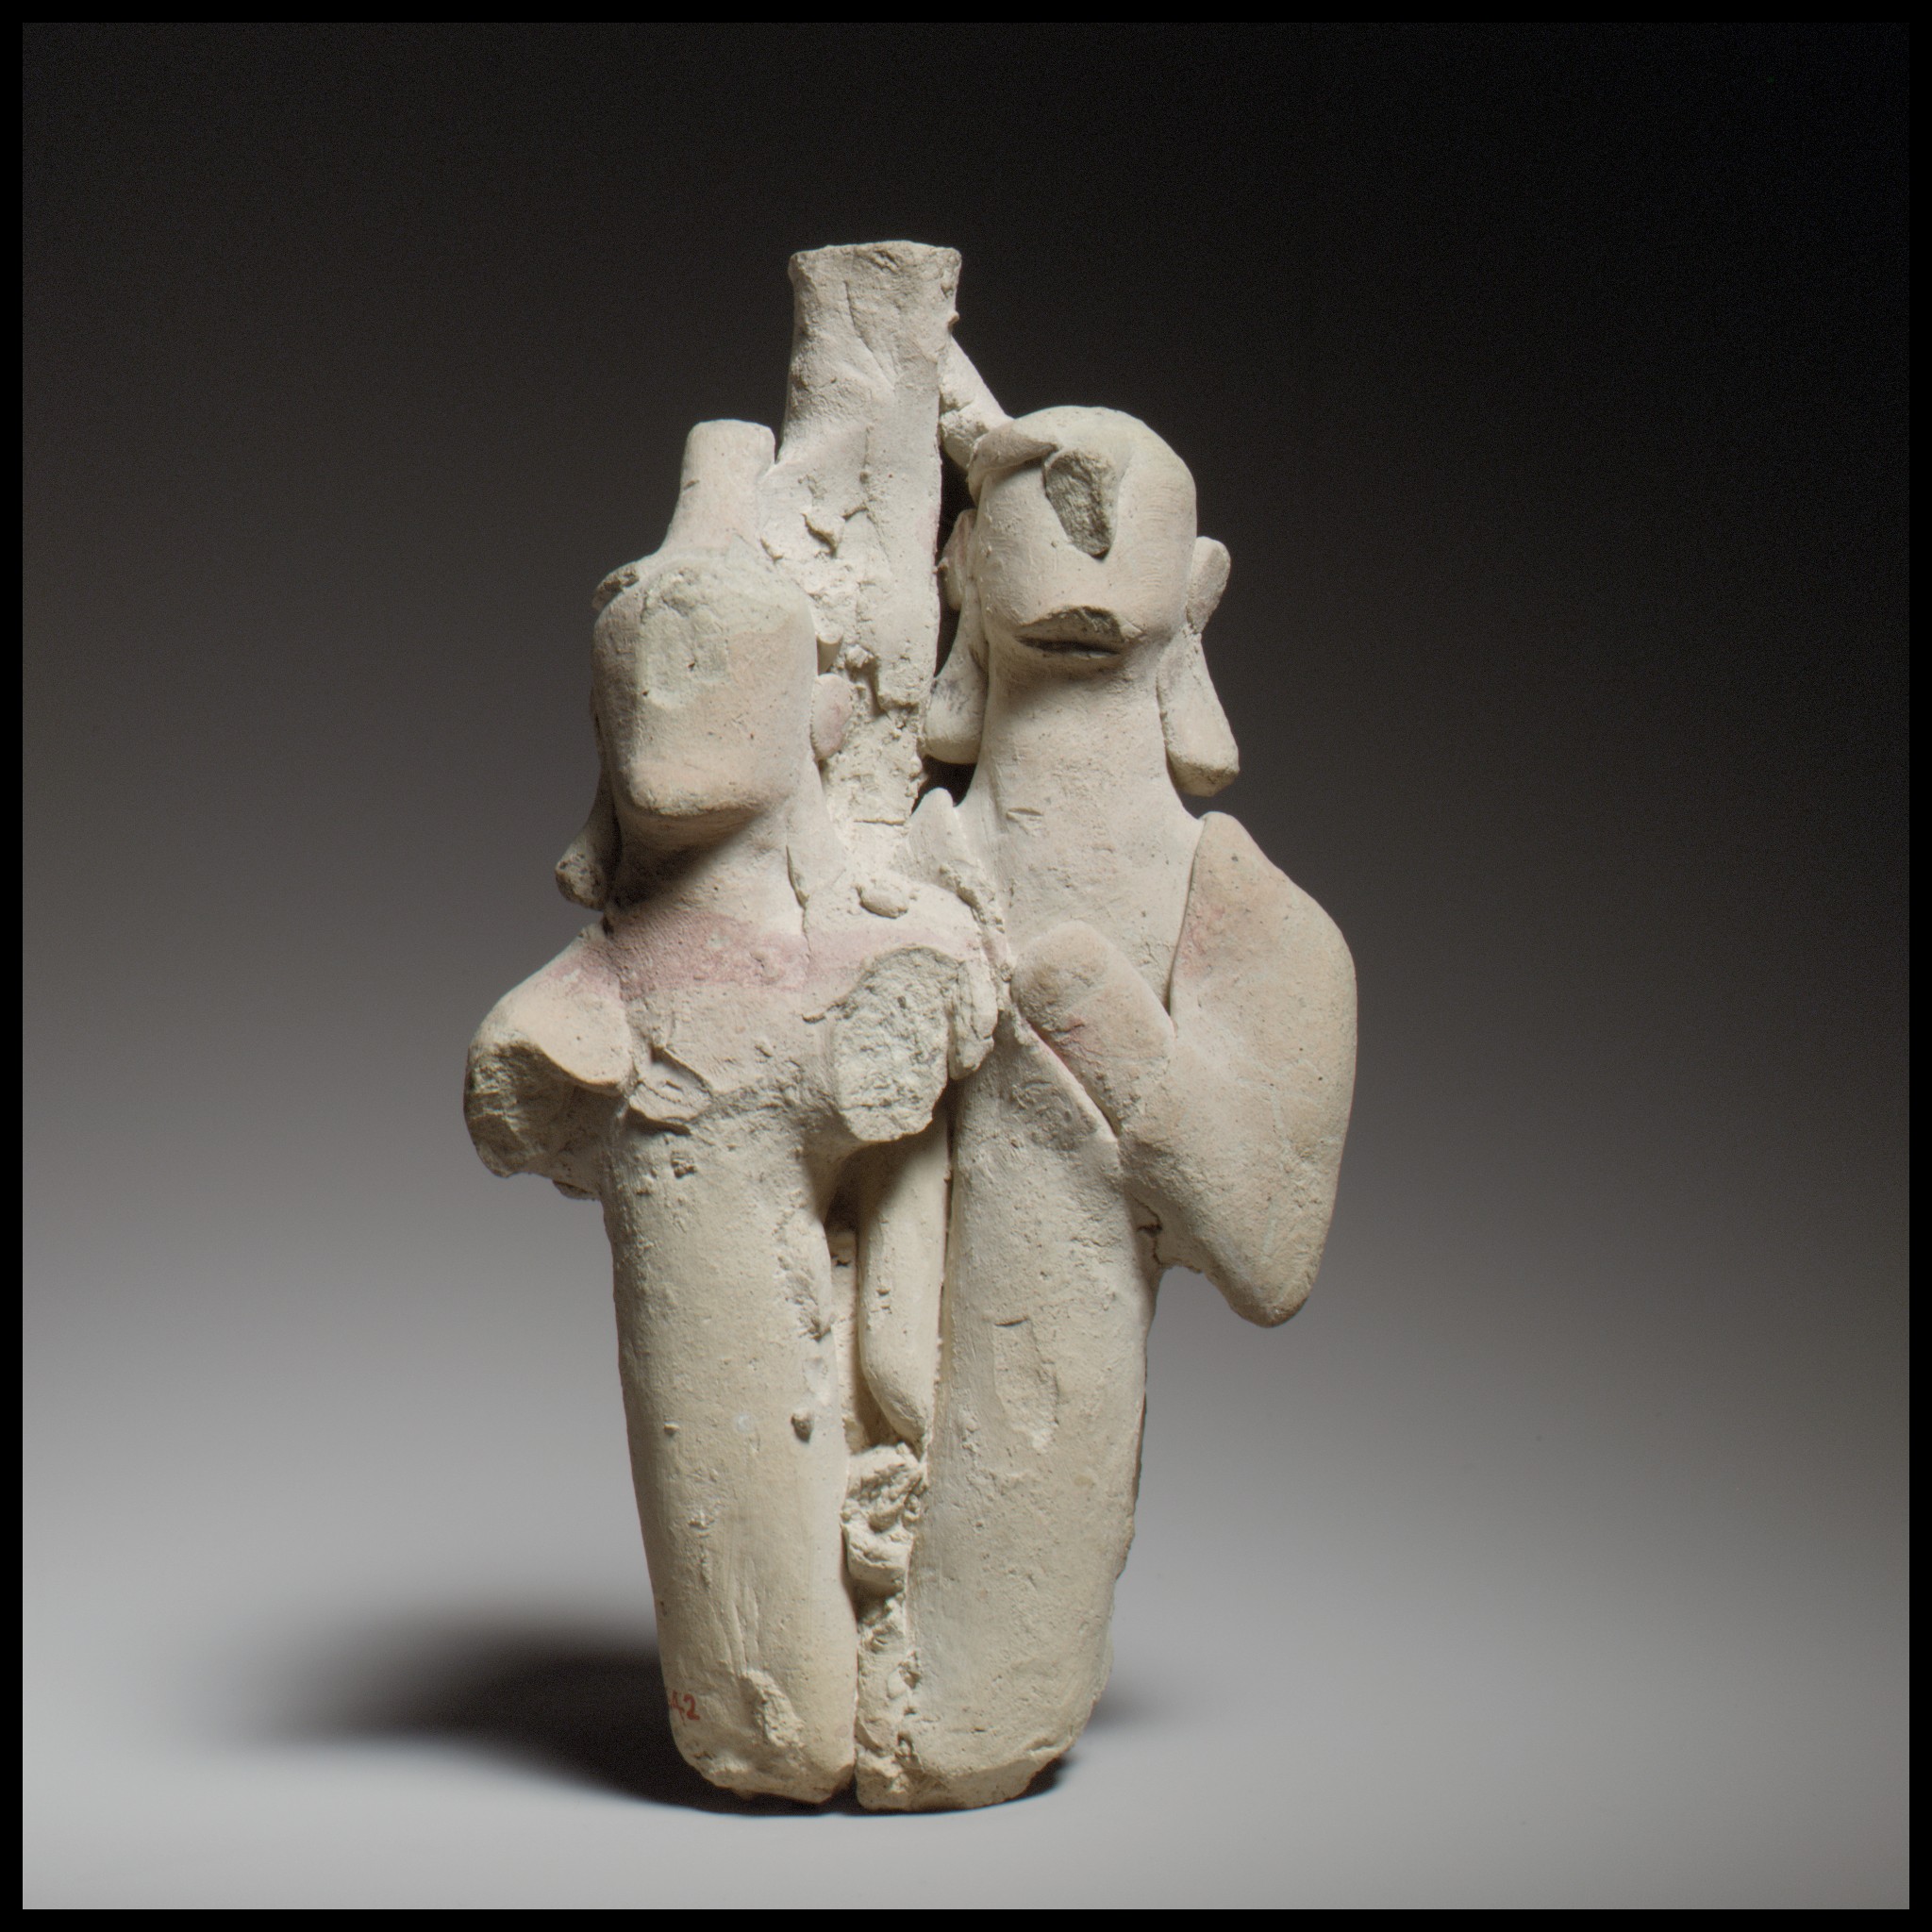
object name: statuette of a female from a ring dance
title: Group of three standing male figures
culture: cypriot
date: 600-501 BCE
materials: terracotta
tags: men